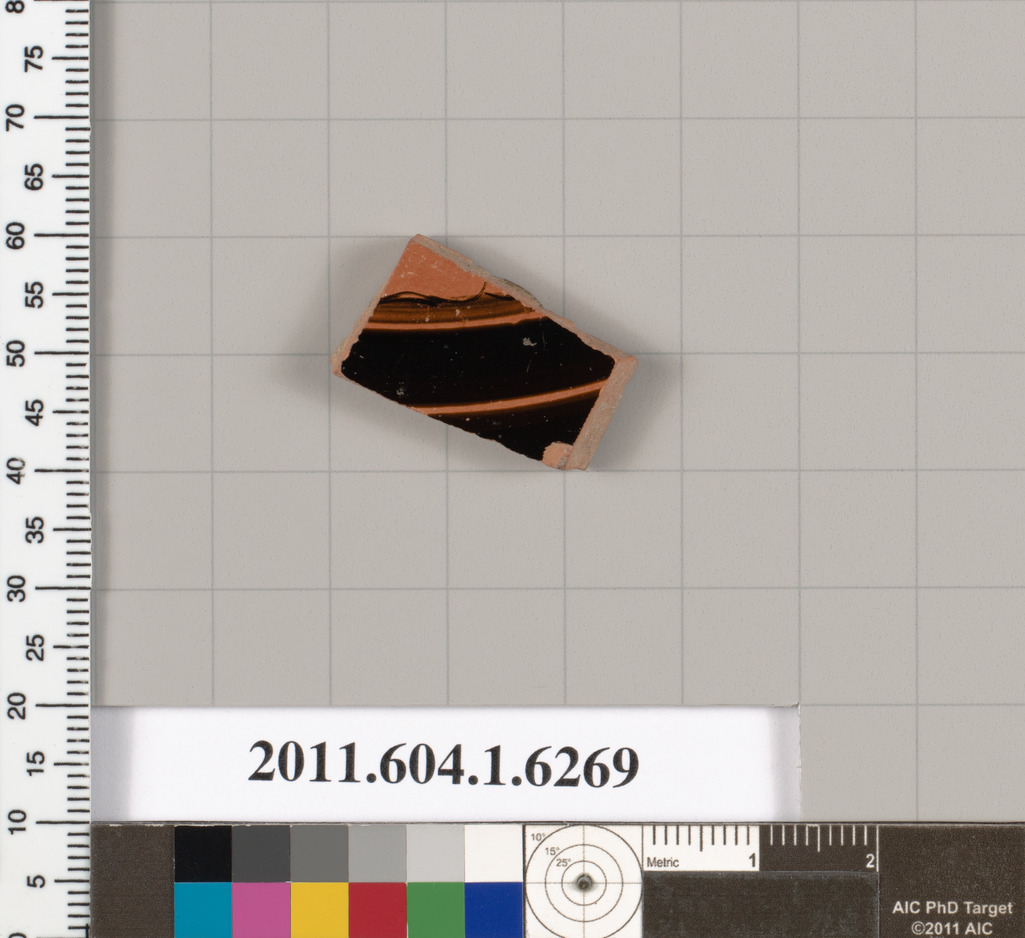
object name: kylix fragment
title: Terracotta fragment of a kylix (drinking cup)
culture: greek, attic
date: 500-480 BCE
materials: terracotta